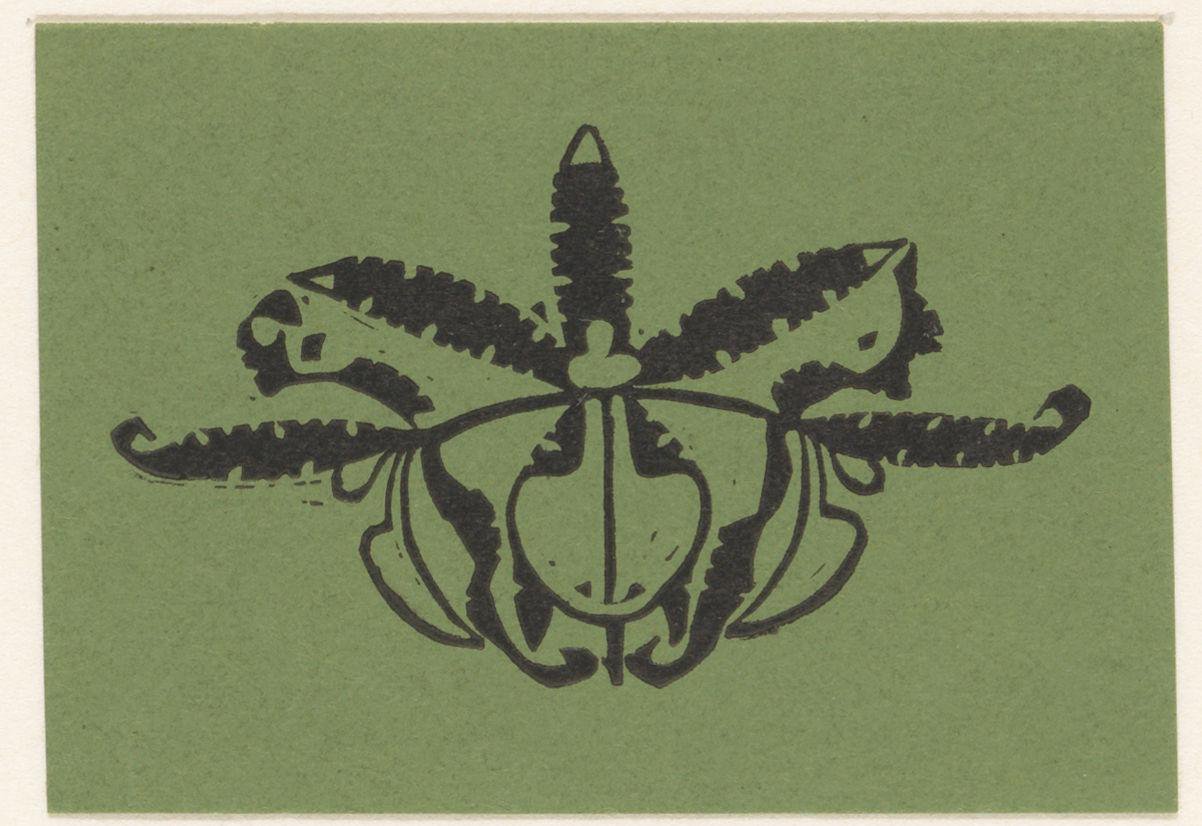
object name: print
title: Vignet met orchidee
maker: gerrit willem dijsselhof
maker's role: designer, draughtsman, print maker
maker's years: 1866-1924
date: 1892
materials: paper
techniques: woodcut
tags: flowers: orchid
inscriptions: collector's mark: Lugt 2228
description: Gerrit Willem Dijsselhof vervaardigde zevenentwintig vignetten voor de gedichtenbundel 'Verzen' van Willem Kloos, die zou verschijnen bij de uitgeverij W. Versluys. Dit vignet is er daar één van. Hoewel de uitvoering van het boek in een ver stadium was, is het uiteindelijk nooit verschenen. De vignetten zijn later wel voor diverse andere doeleinden gebruikt.